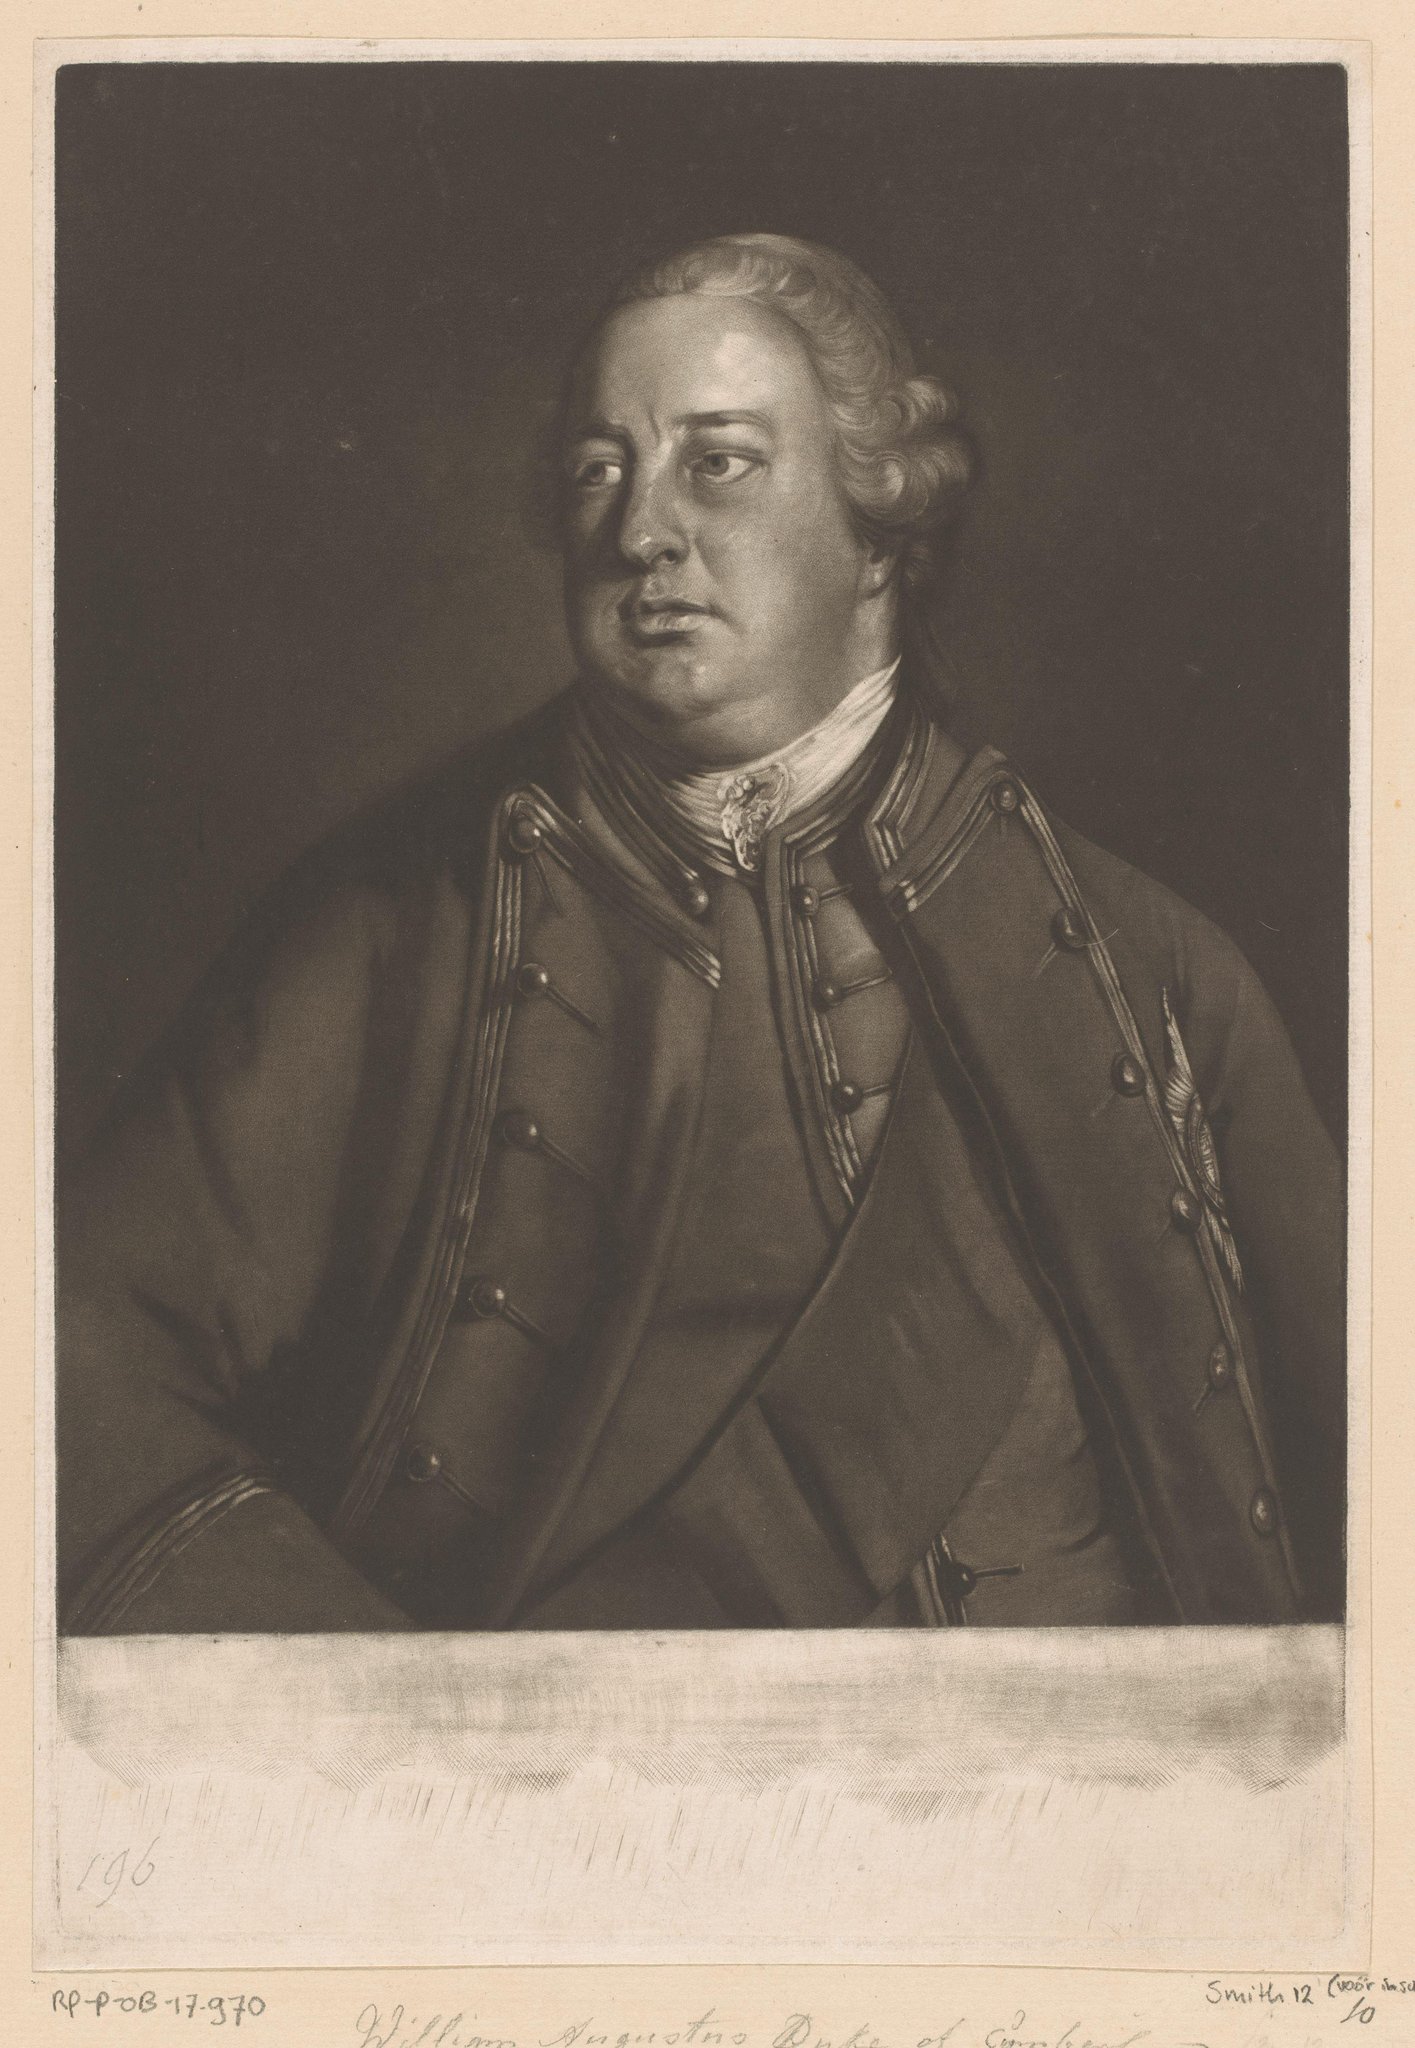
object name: print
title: Portret van Willem Augustus van Cumberland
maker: edward fisher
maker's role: print maker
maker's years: 1722-1785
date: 1760-1765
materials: paper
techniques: mezzotint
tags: commander-in-chief, general, marshal, historical persons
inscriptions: collector's mark: Lugt 240